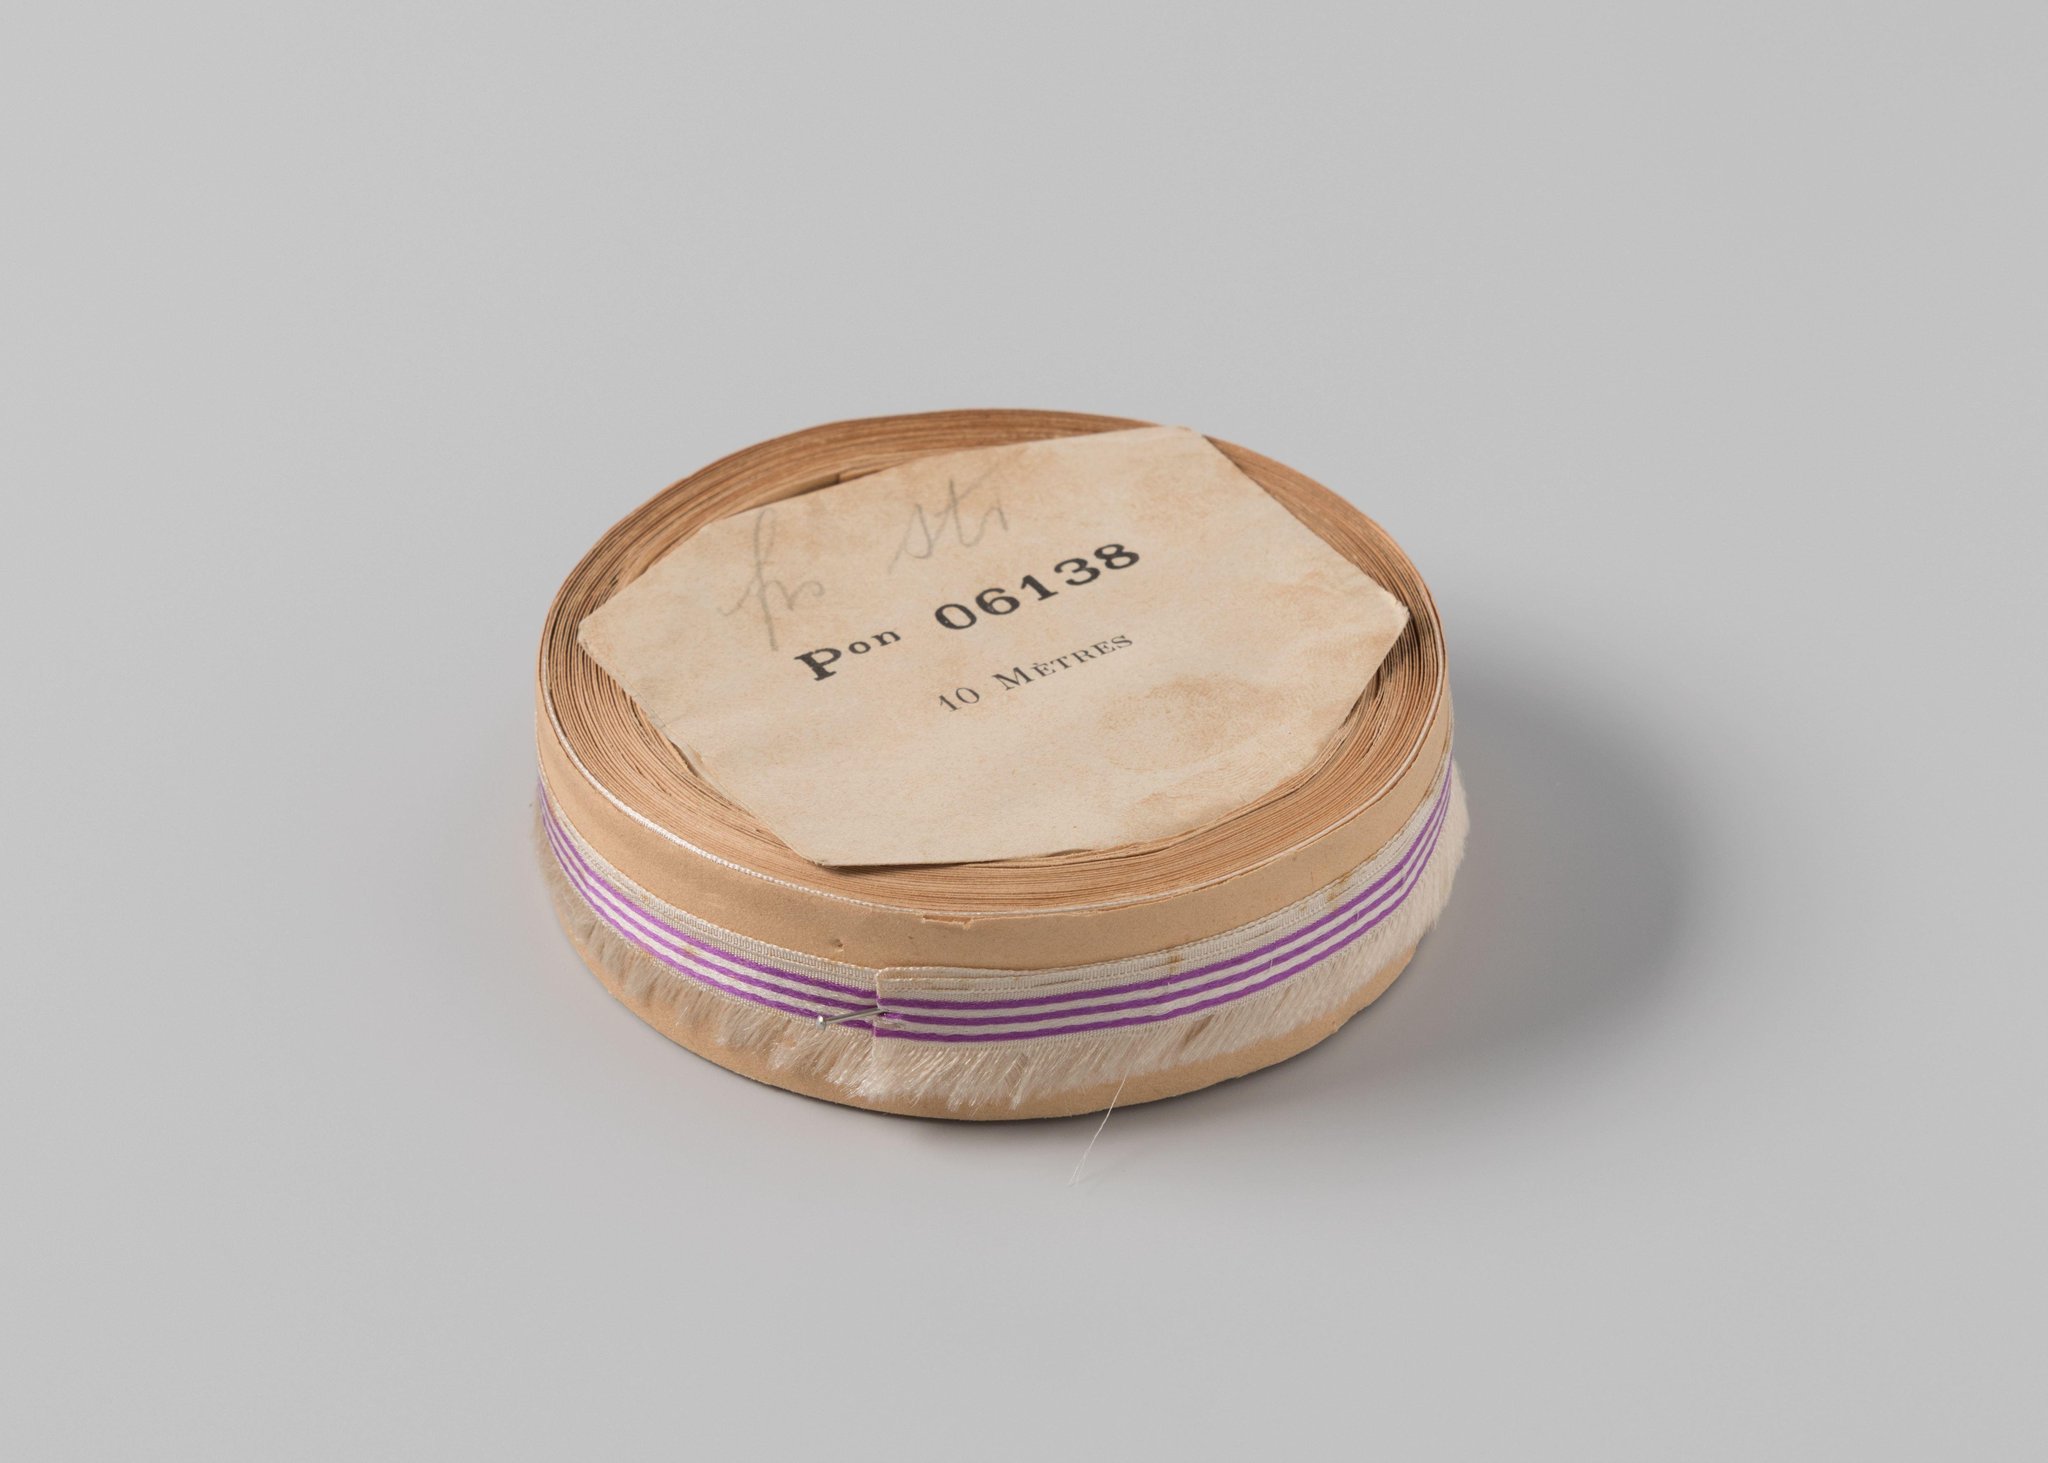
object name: ribbon material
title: Rol met wit lint met één gerafelde zijde en drie paarse horizontale strepen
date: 1930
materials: cardboard, paper, textile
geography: france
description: Rol met wit lint met één gerafelde zijde en drie paarse horizontale strepen.